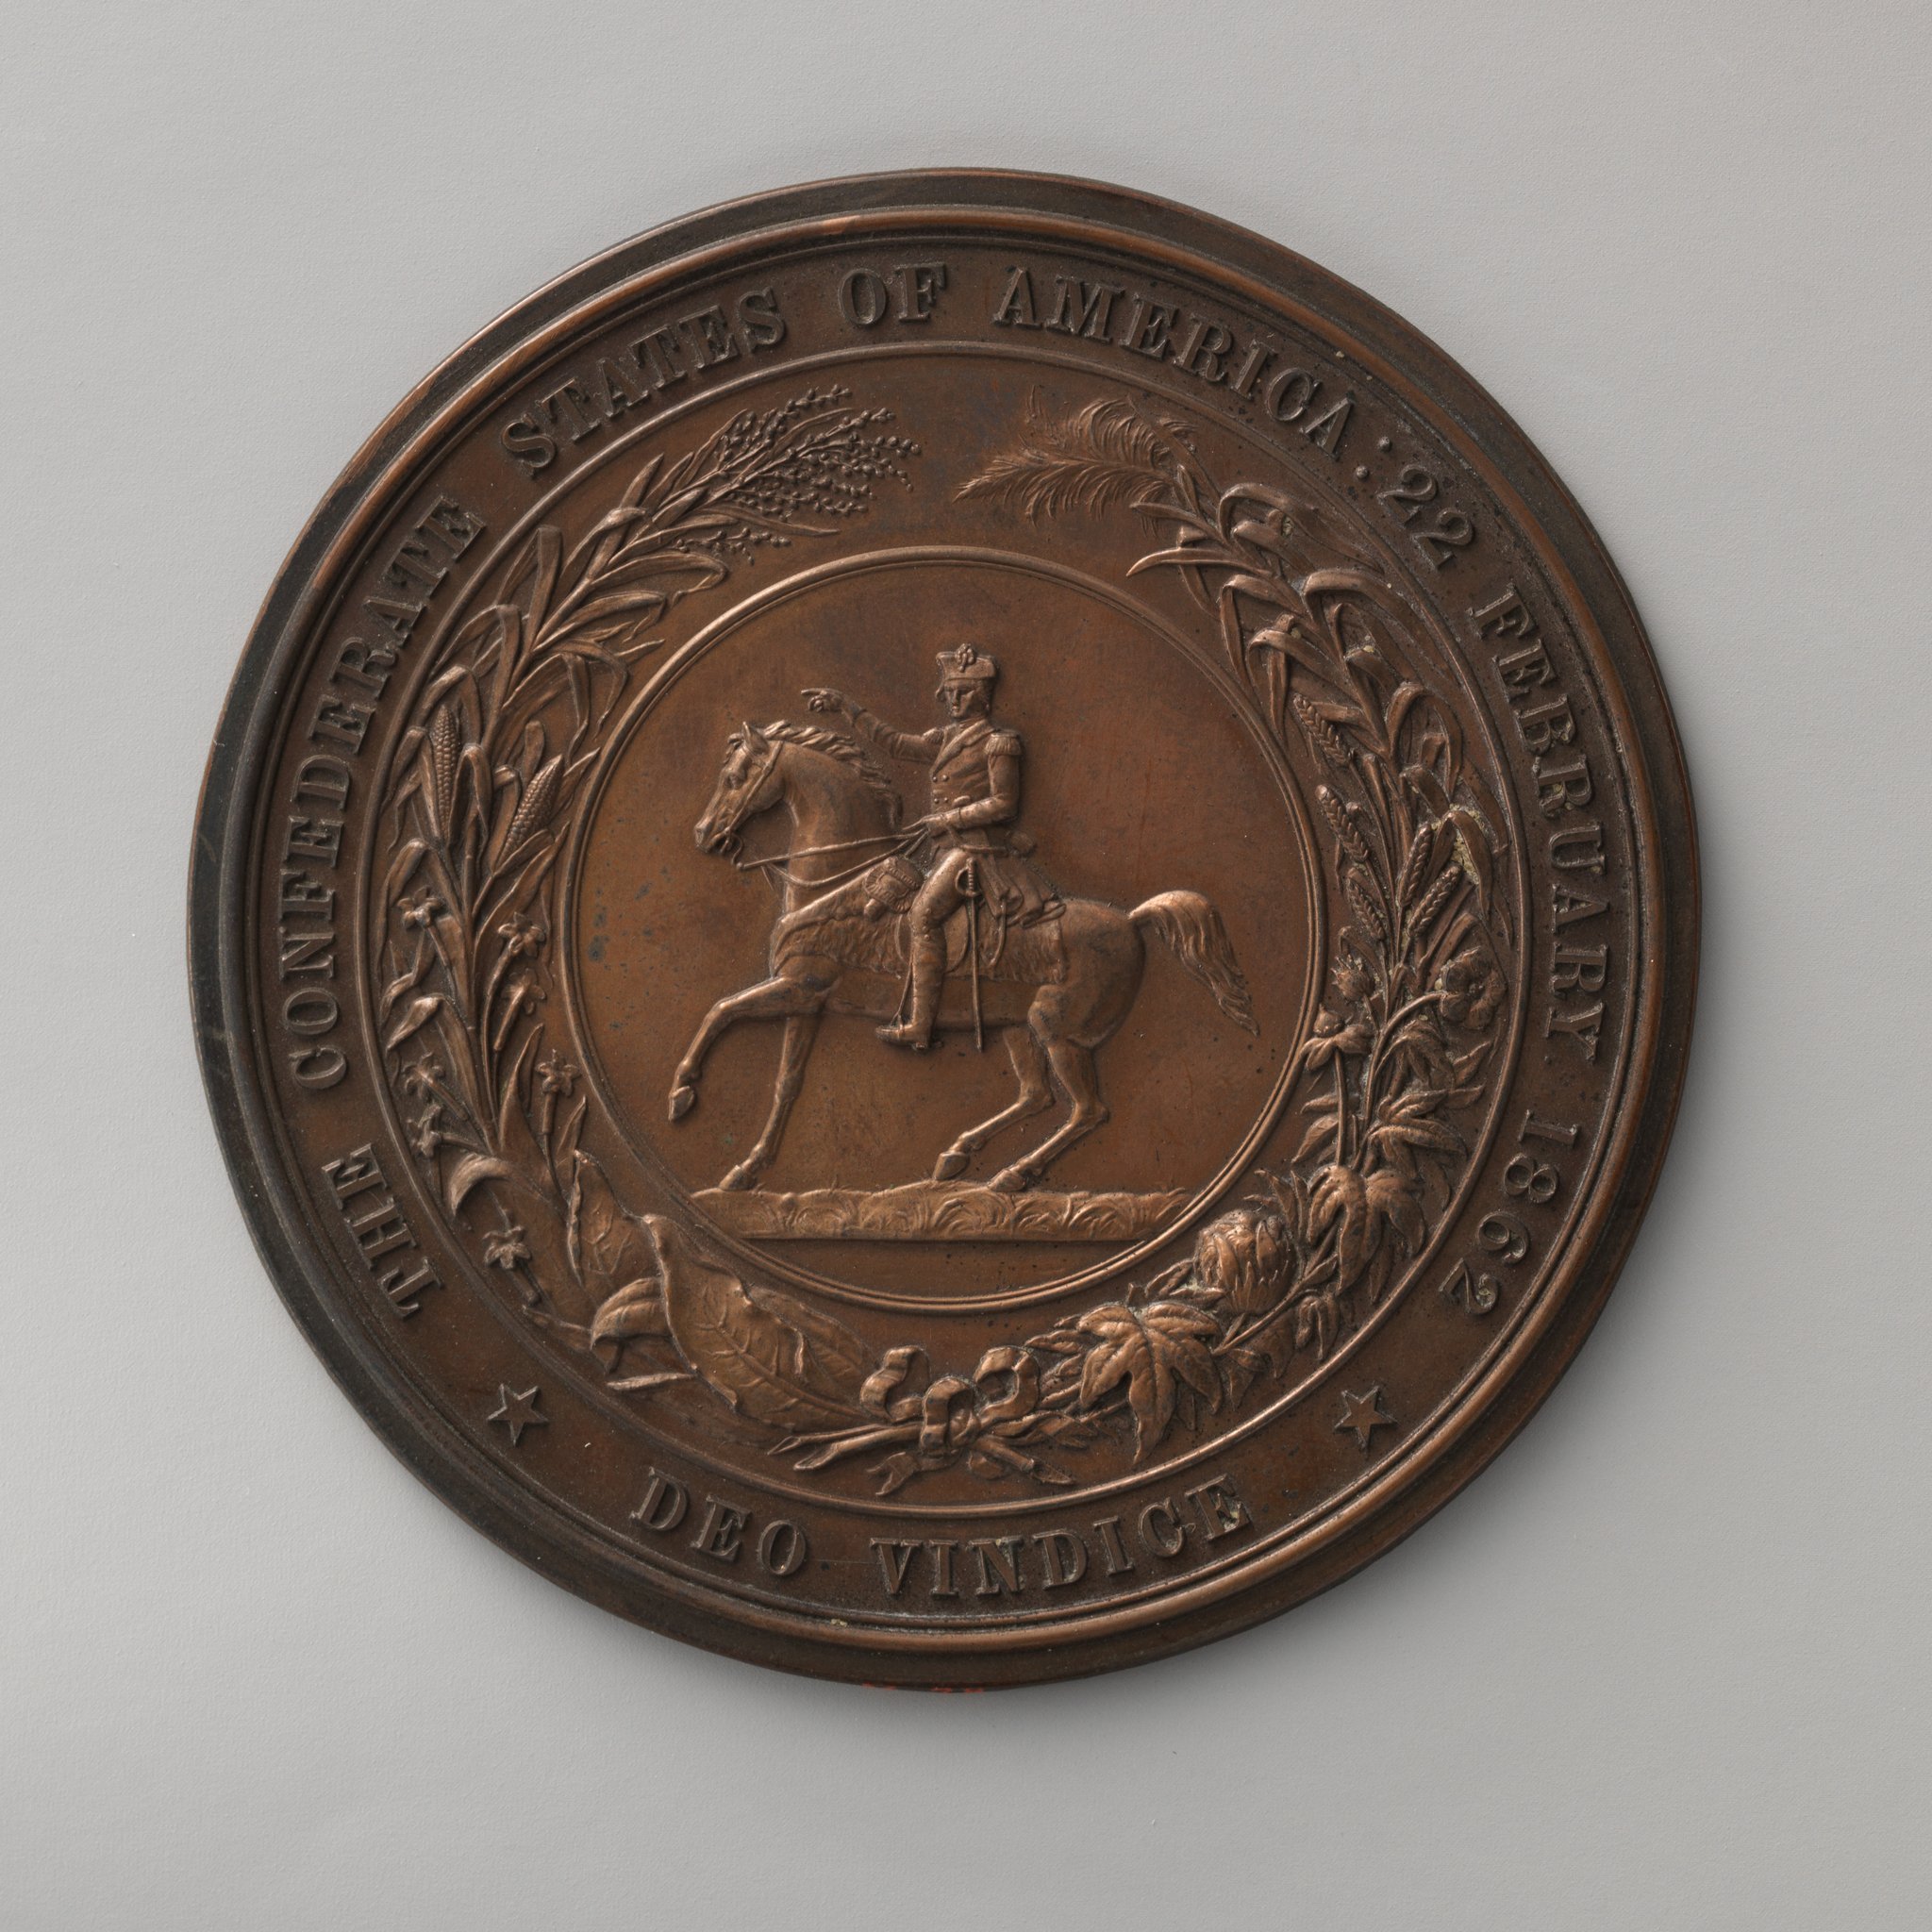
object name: disk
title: Impress of the seal of the Confederate States, 1862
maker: p. a. foley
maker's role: artist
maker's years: 1818-1872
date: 1864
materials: bronze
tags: men,horses